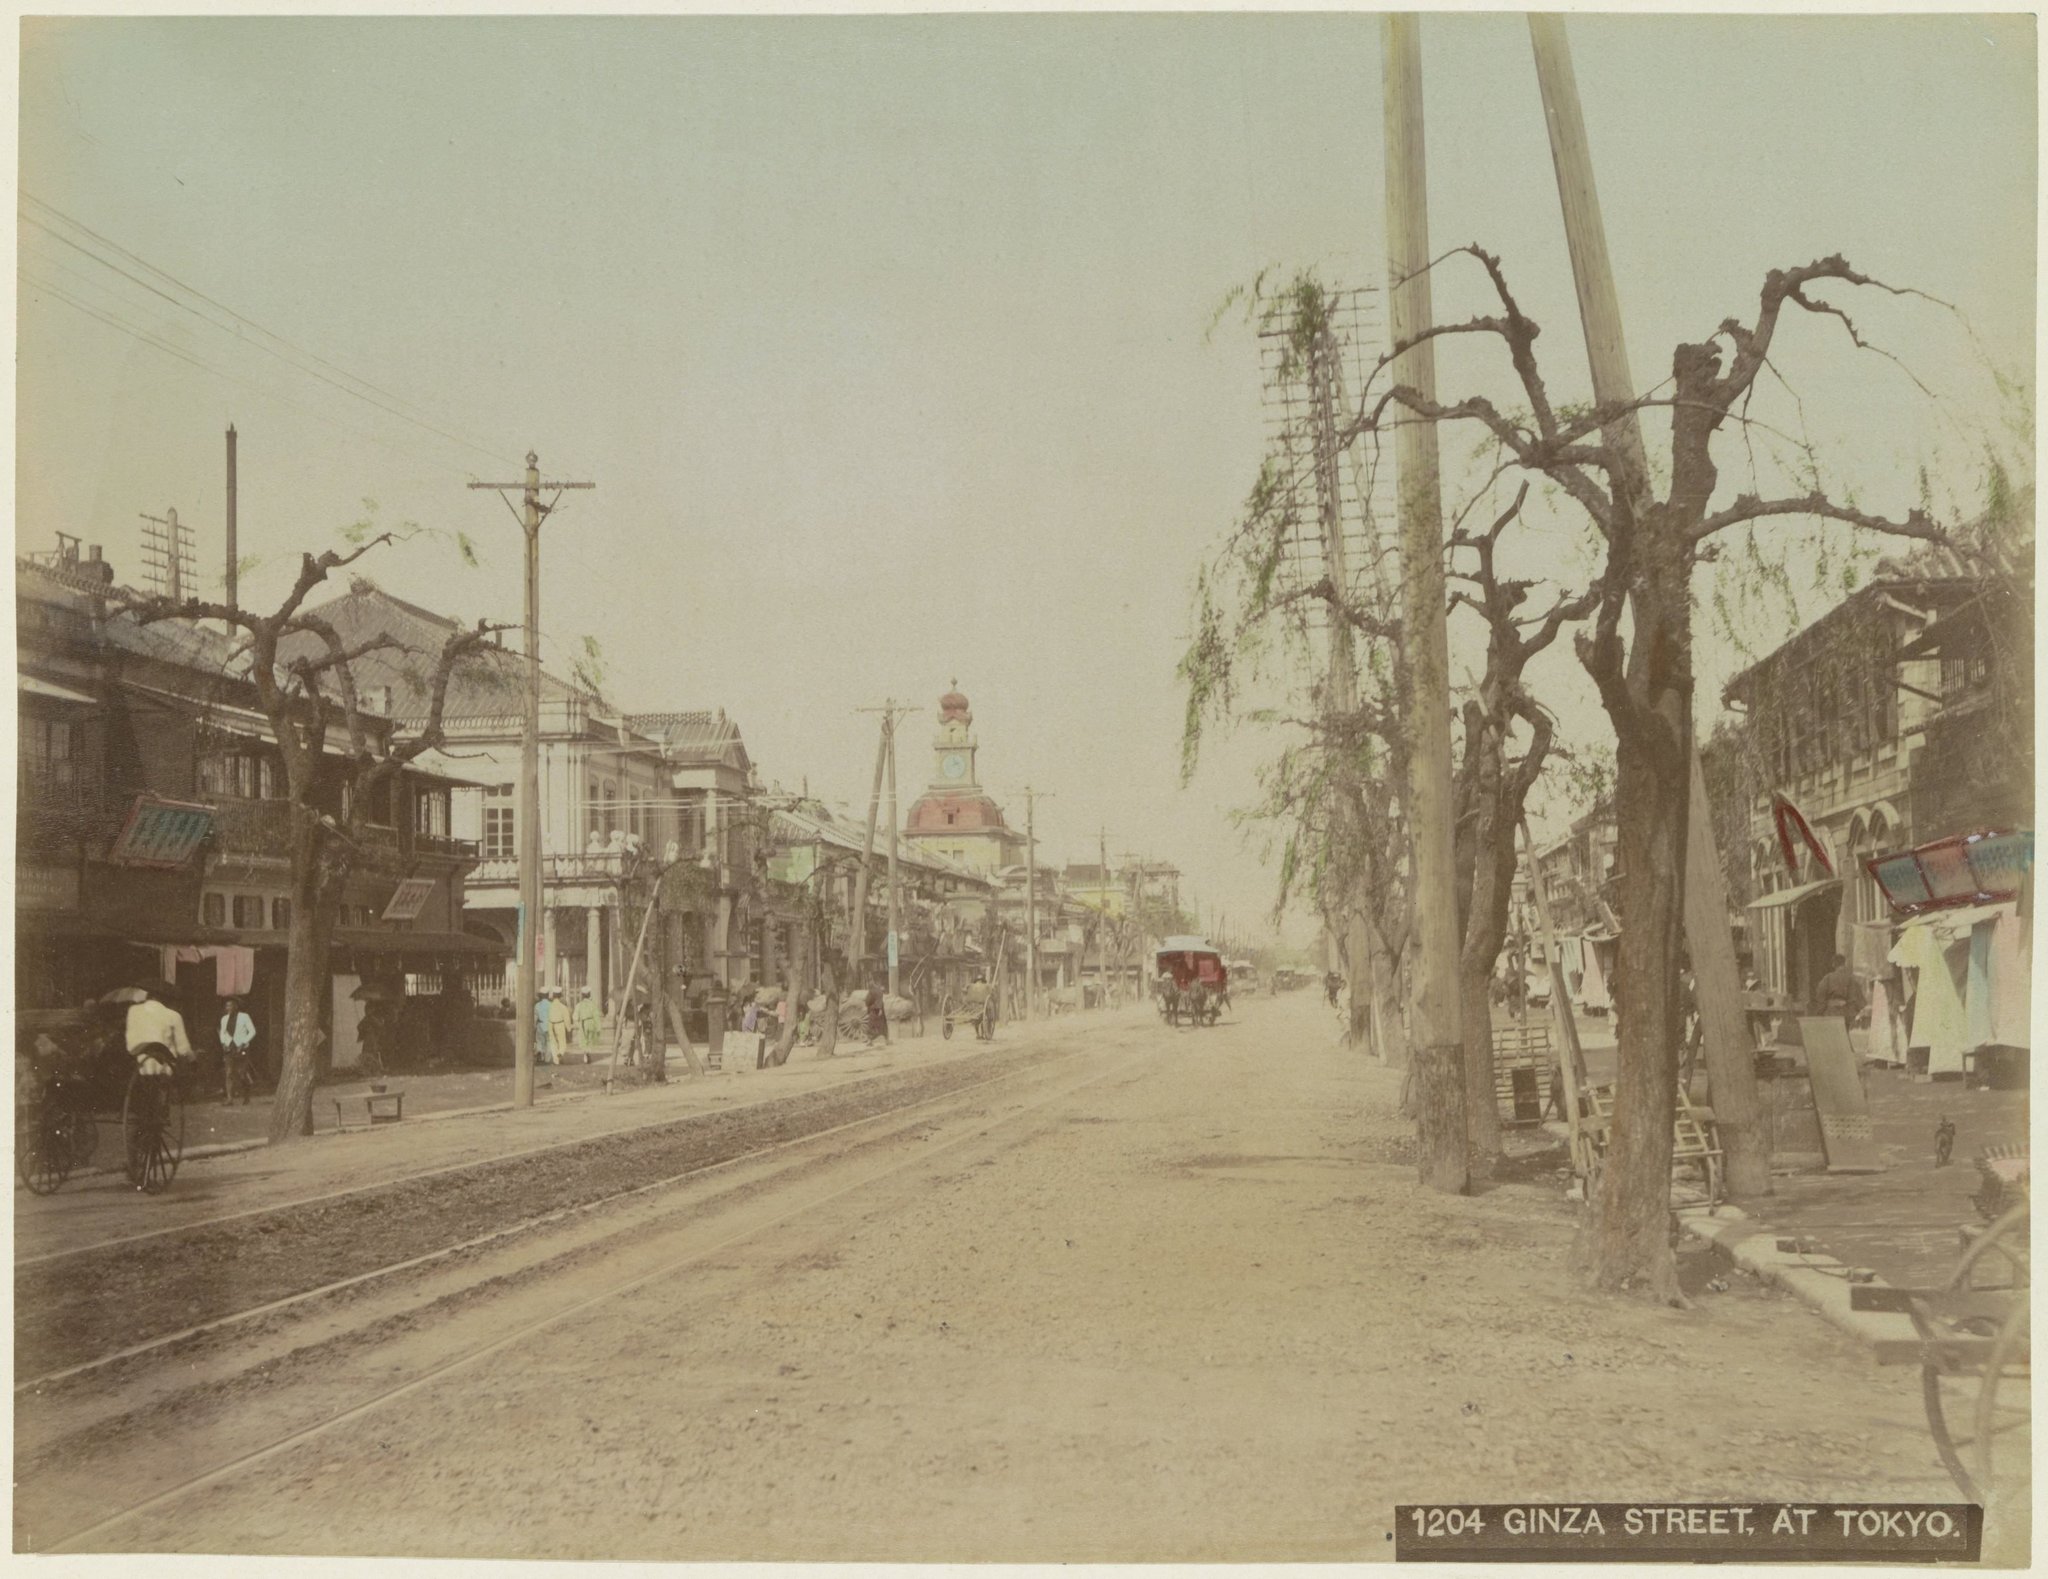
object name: photograph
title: Ginza Street, at Tokyo.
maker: Anonymous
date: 1870-1900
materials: cardboard, paper, photographic support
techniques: albumen print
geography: tokyo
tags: shop, store, diligence, omnibus, horse-tram, telegraph pole, telephone pole, street (+ city(-scape) with figures, staffage)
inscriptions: negative number: ‘1204’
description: Onderdeel van Reisalbum met foto's van bezienswaardigheden in Japan.